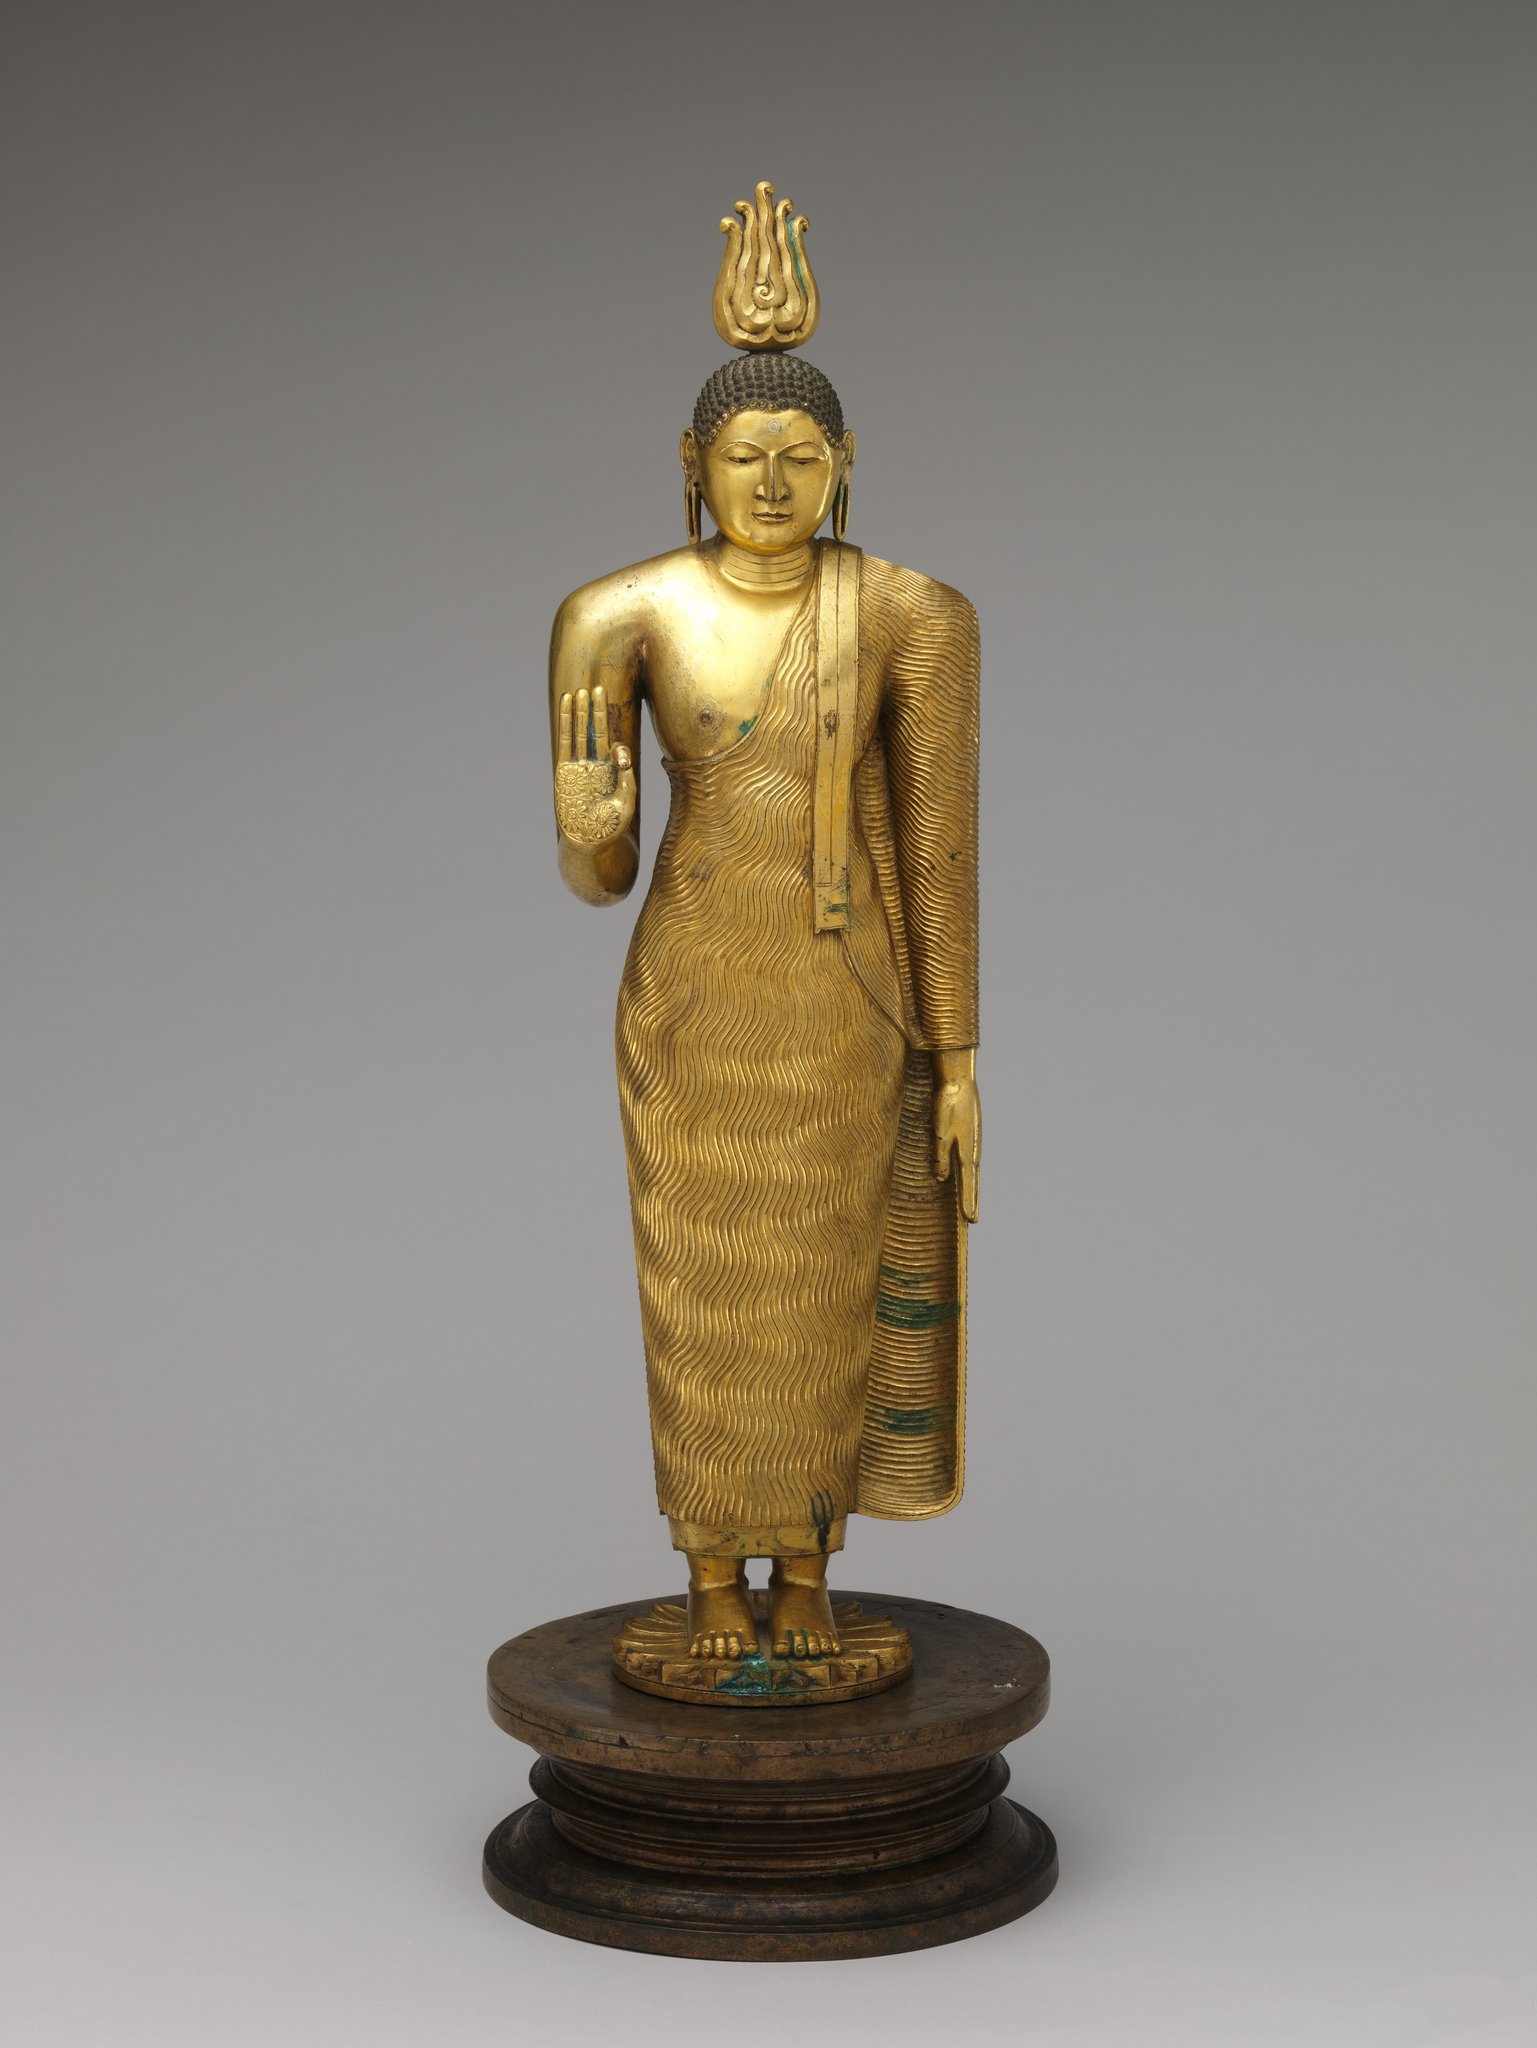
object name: figure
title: Buddha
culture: sri lanka, kandy district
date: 1701-1800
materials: copper alloy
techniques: gilding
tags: buddhism,buddha